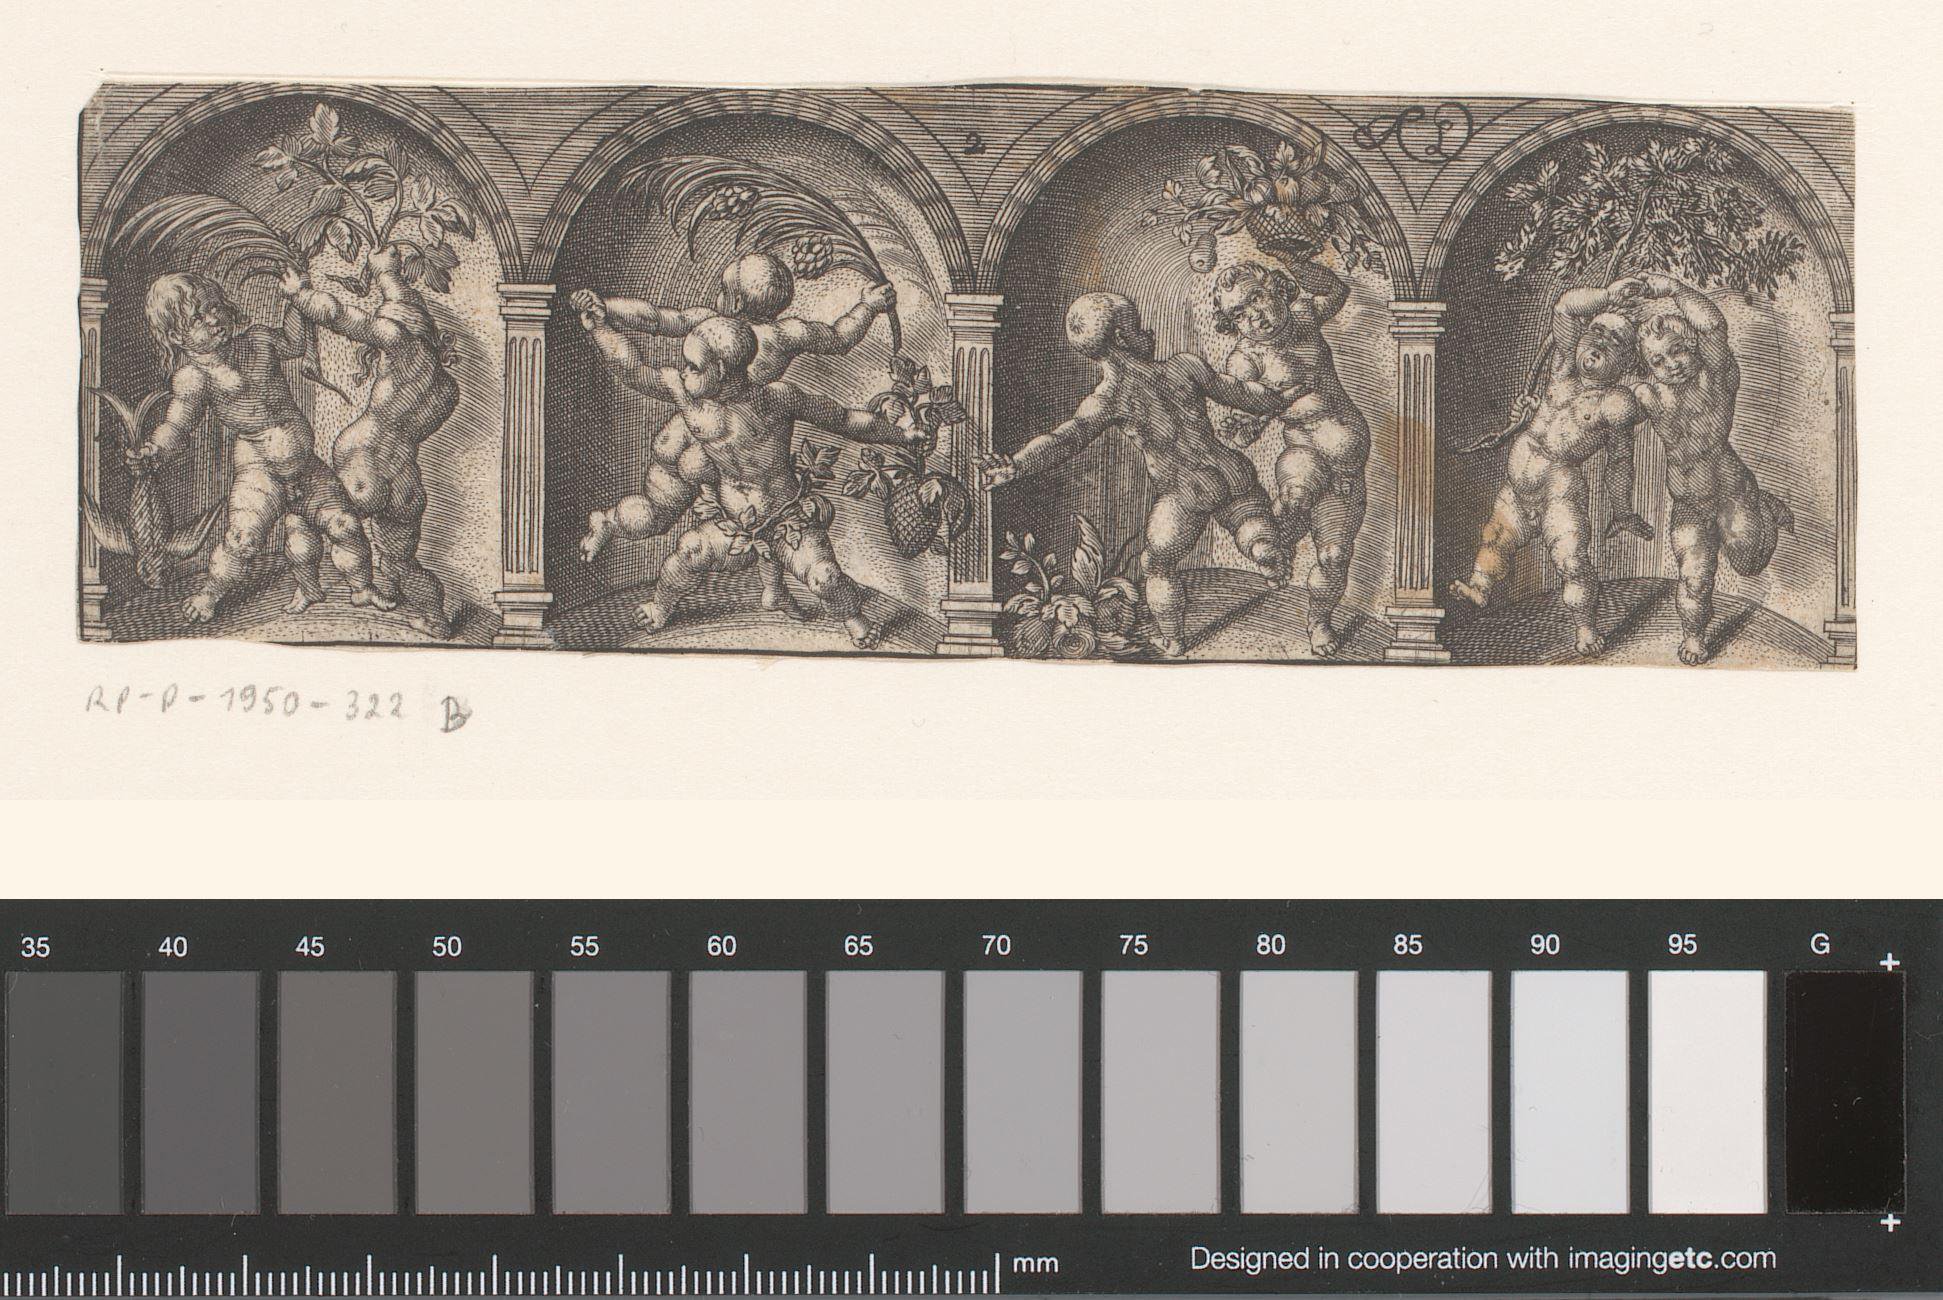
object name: print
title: Figuren in beweging, gevat in architecturale niches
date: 1610-1640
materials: paper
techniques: engraving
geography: france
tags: parts of church interior: niche, dancing, cupids: 'amores', 'amoretti', 'putti'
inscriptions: collector's mark: Lugt 2228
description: In deze serie worden naakte figuren in vier architecturale niches geplaatst. Zij stellen de inwoners voor van de Nieuwe Wereld.